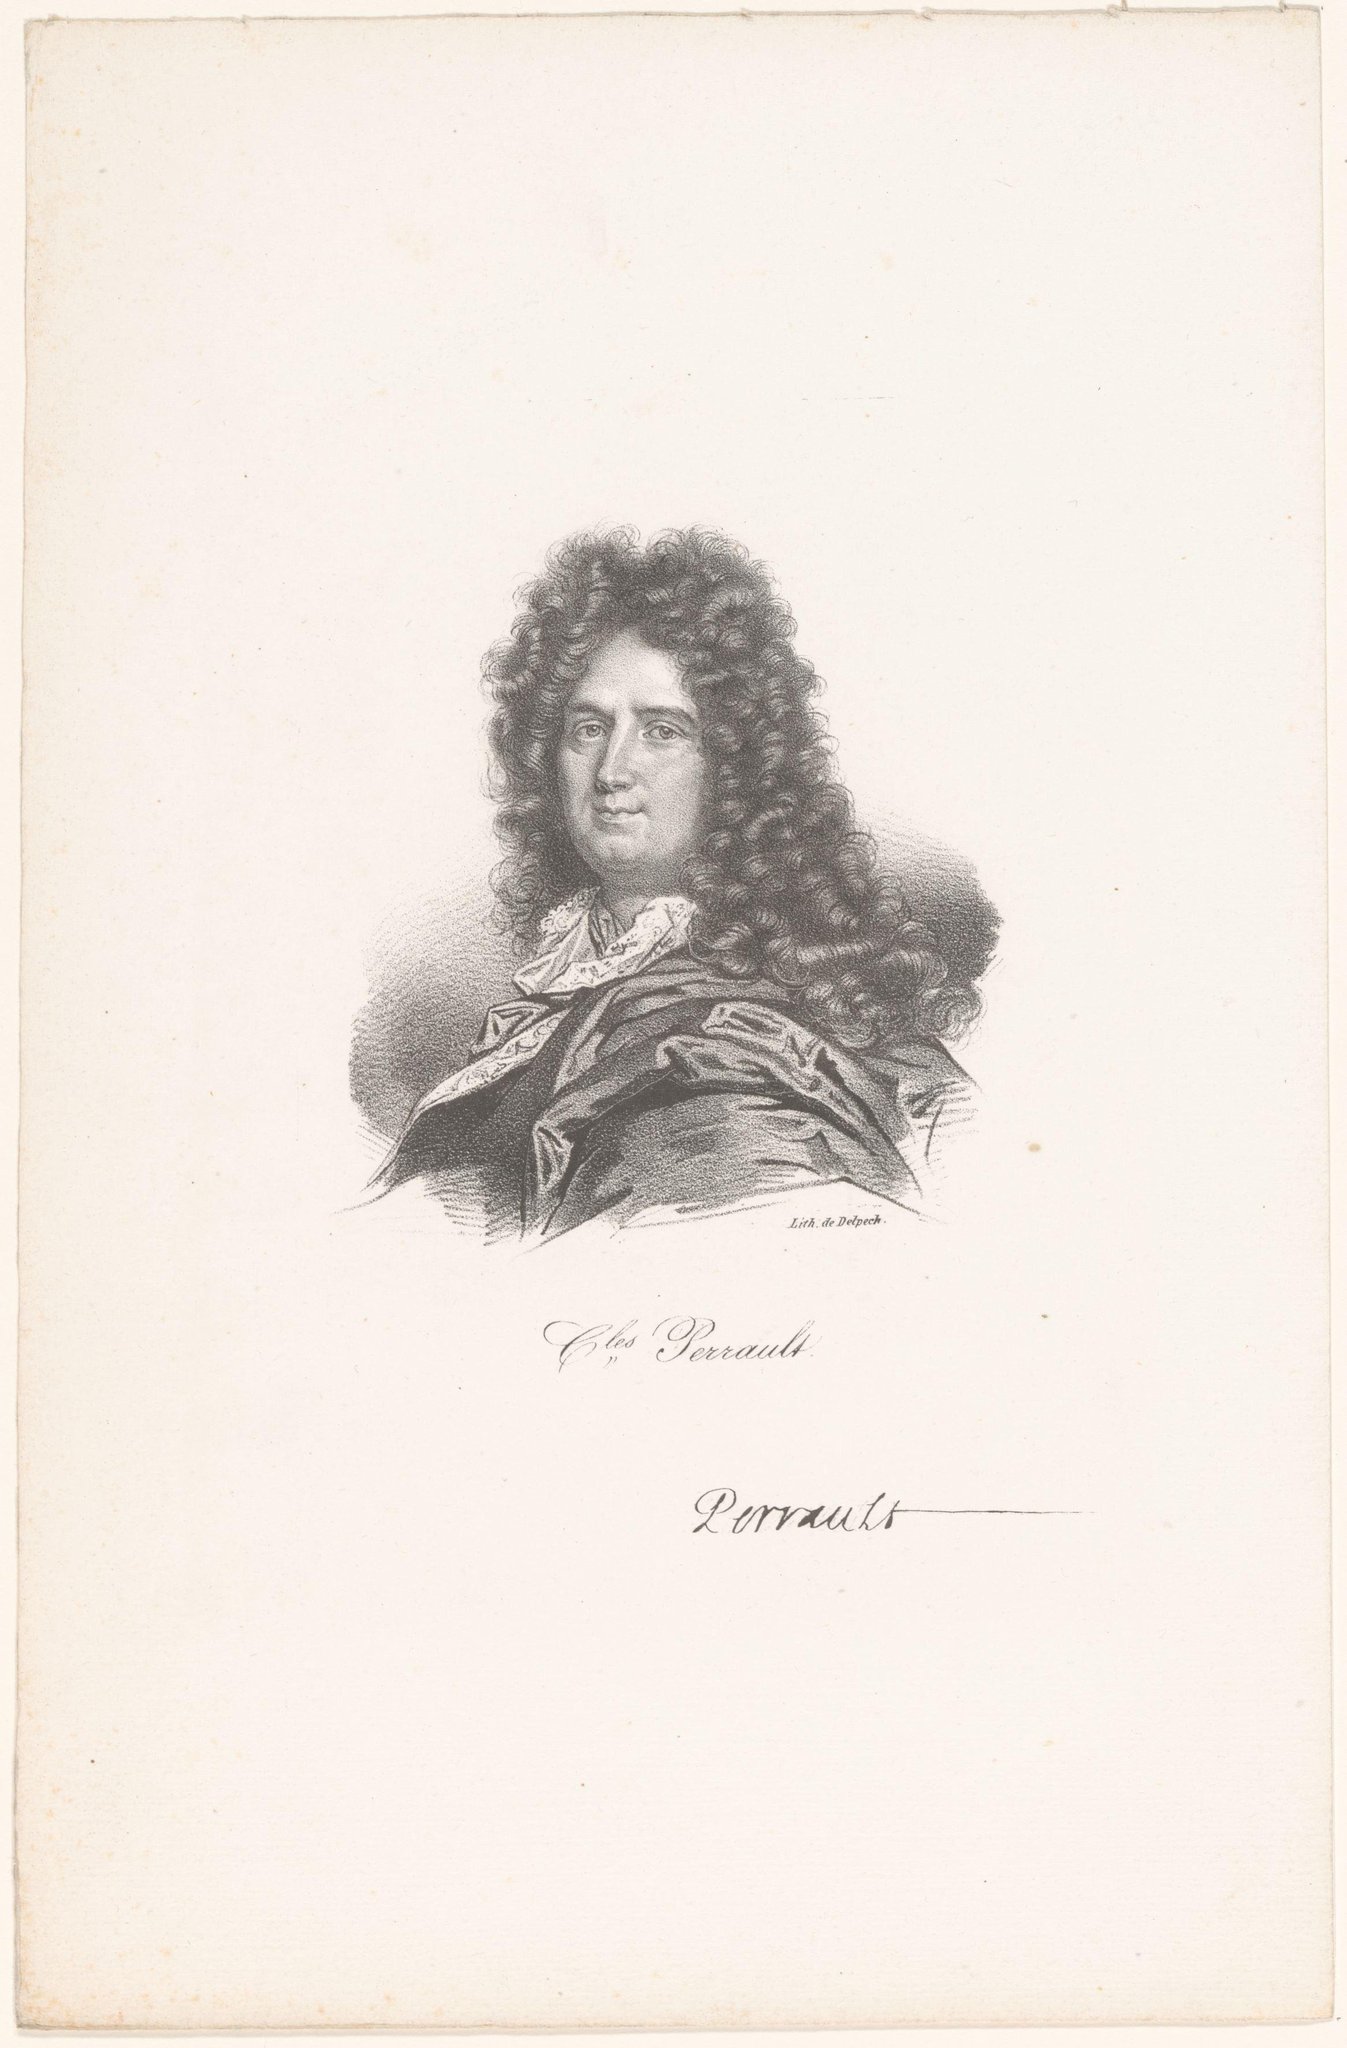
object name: print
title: C.les Perrault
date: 1838-1842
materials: paper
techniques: lithograph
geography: paris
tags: paris, charles perrault, historical persons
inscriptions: collector's mark: Lugt 2228a